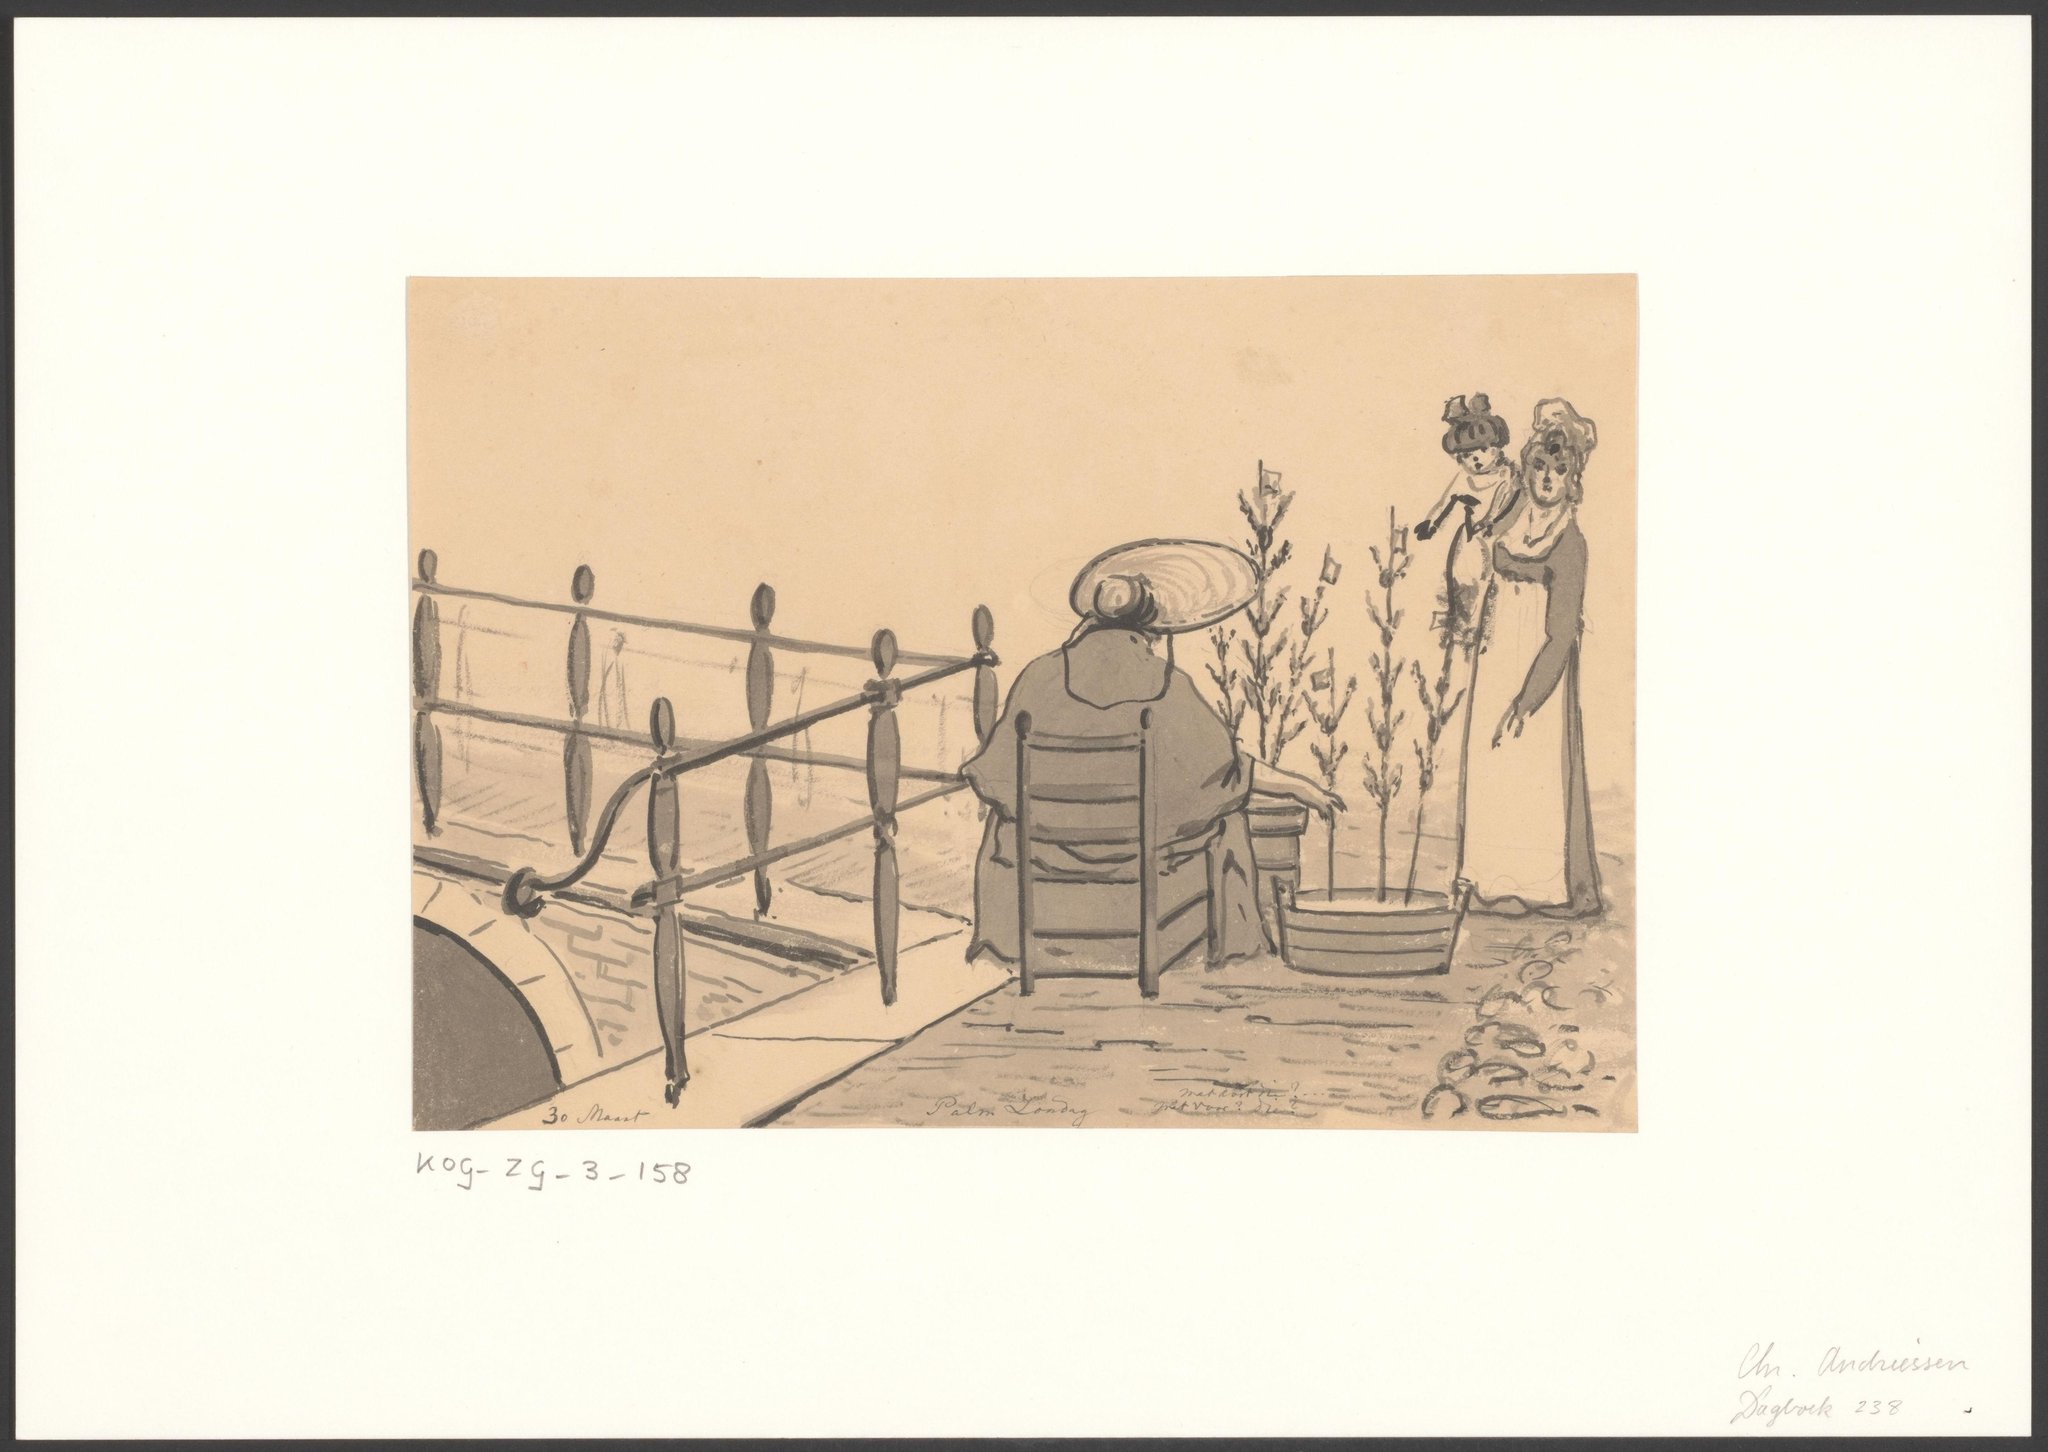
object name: drawing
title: Vrouw met kind koopt een Palmpasen stok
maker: christiaan andriessen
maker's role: draughtsman, print maker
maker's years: 1775-1846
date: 1806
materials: ink, paper, pencil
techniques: brush, pen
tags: persons engaged in trade and commerce - bb - women engaged in trade and commerce, palm sunday, amsterdam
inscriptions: signature: ‘J Andriessen’, inscription: ‘30 maart Palm Zondag Wat kost die? Wat voor? Die?’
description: Dagboekblad uit het getekende dagboek dat Christiaan Andriessen bijhield van 1805 tot en met 1808.